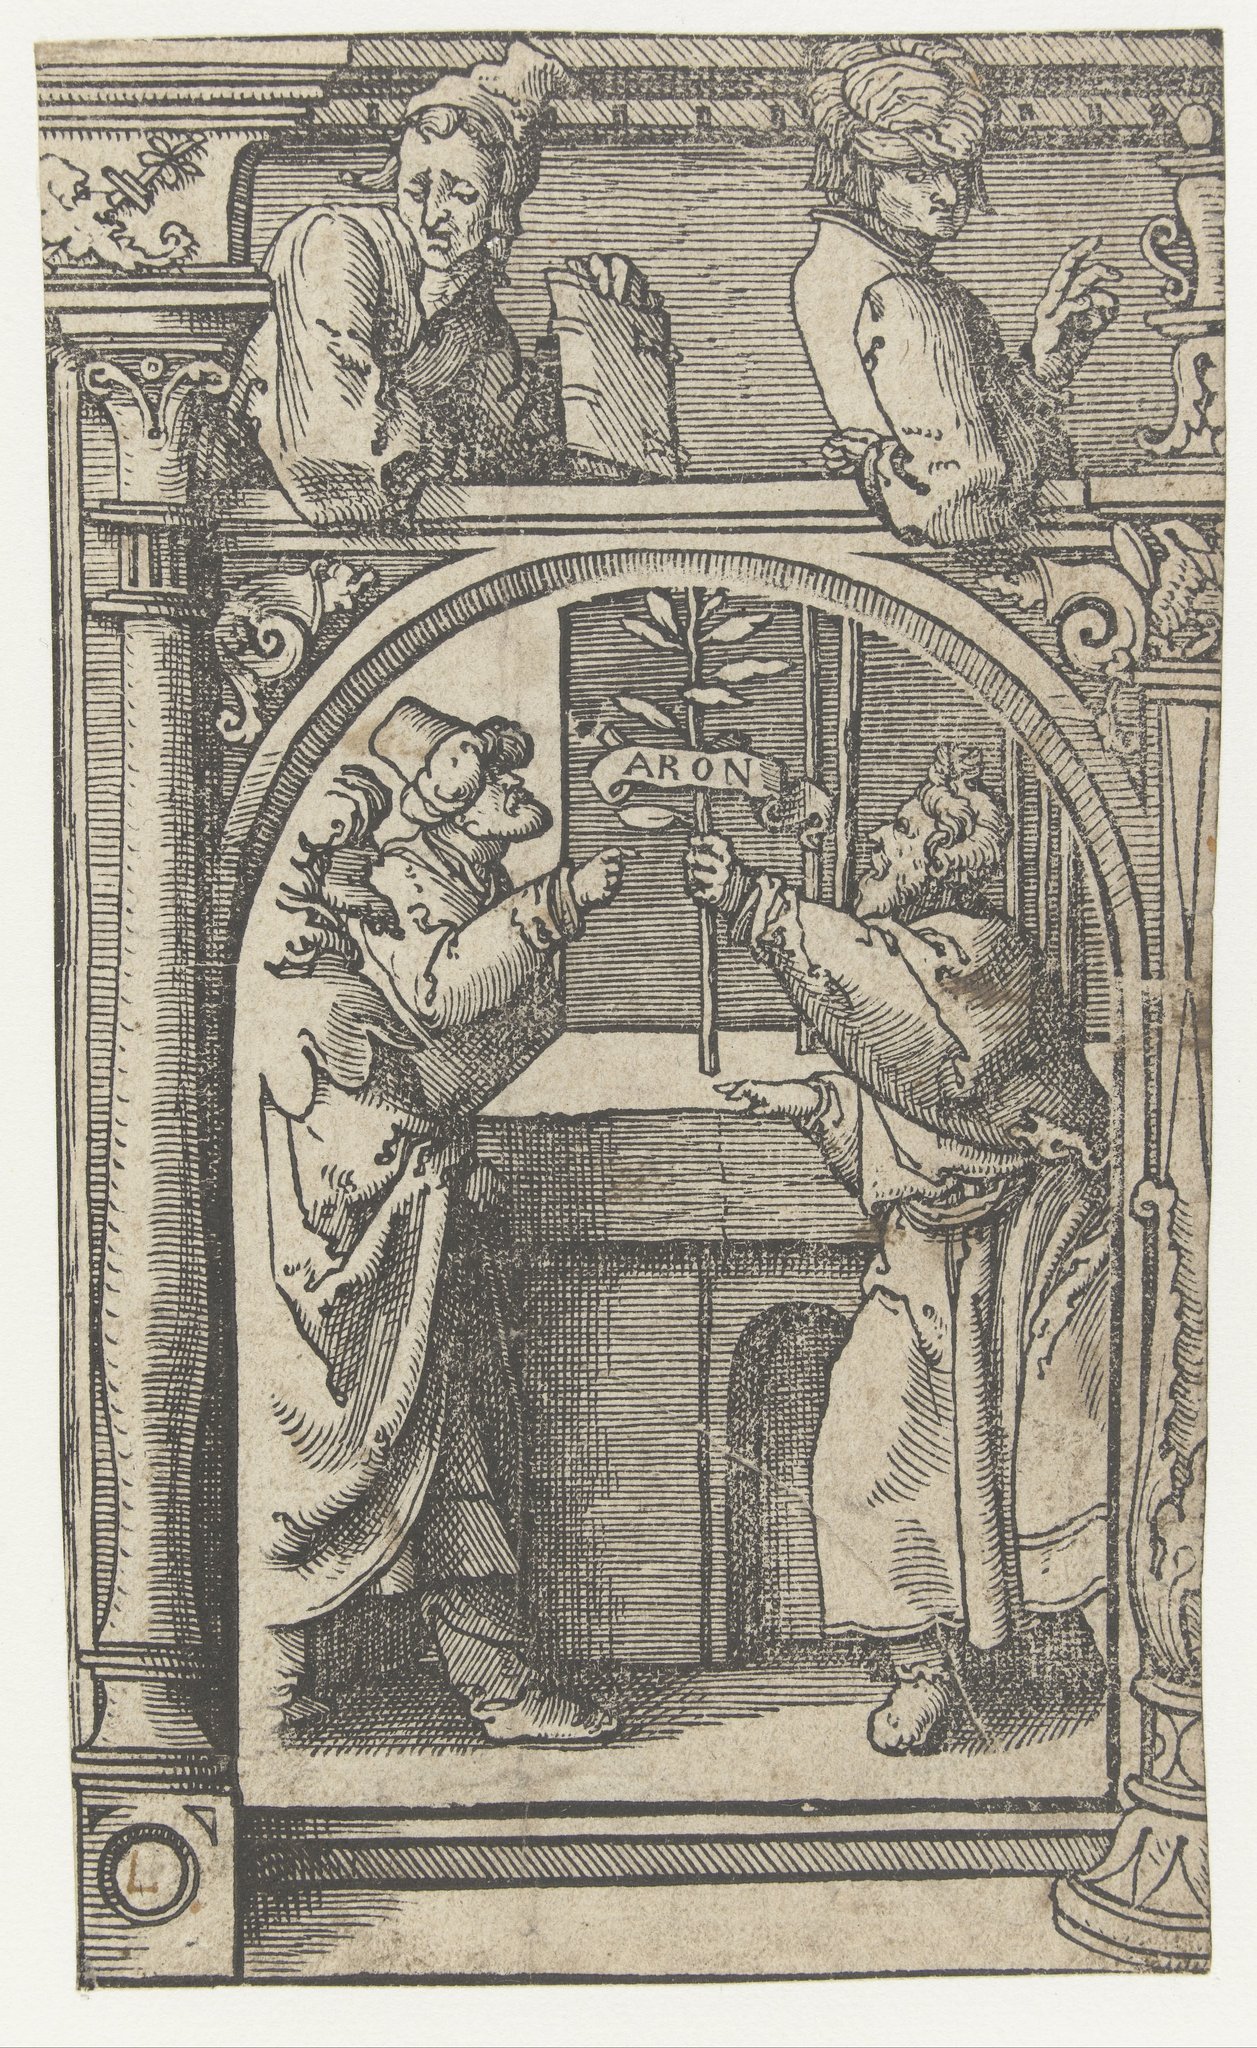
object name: print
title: De staf van Aaron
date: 1525-1530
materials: paper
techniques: woodcut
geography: low countries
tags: moses shows the flowering rod of aaron to the community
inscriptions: collector's mark: Lugt 240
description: Fragment van grotere voorstelling gebruikt in Biblia Pauperum. Mozes toont de bloeiende staf van Aaron.